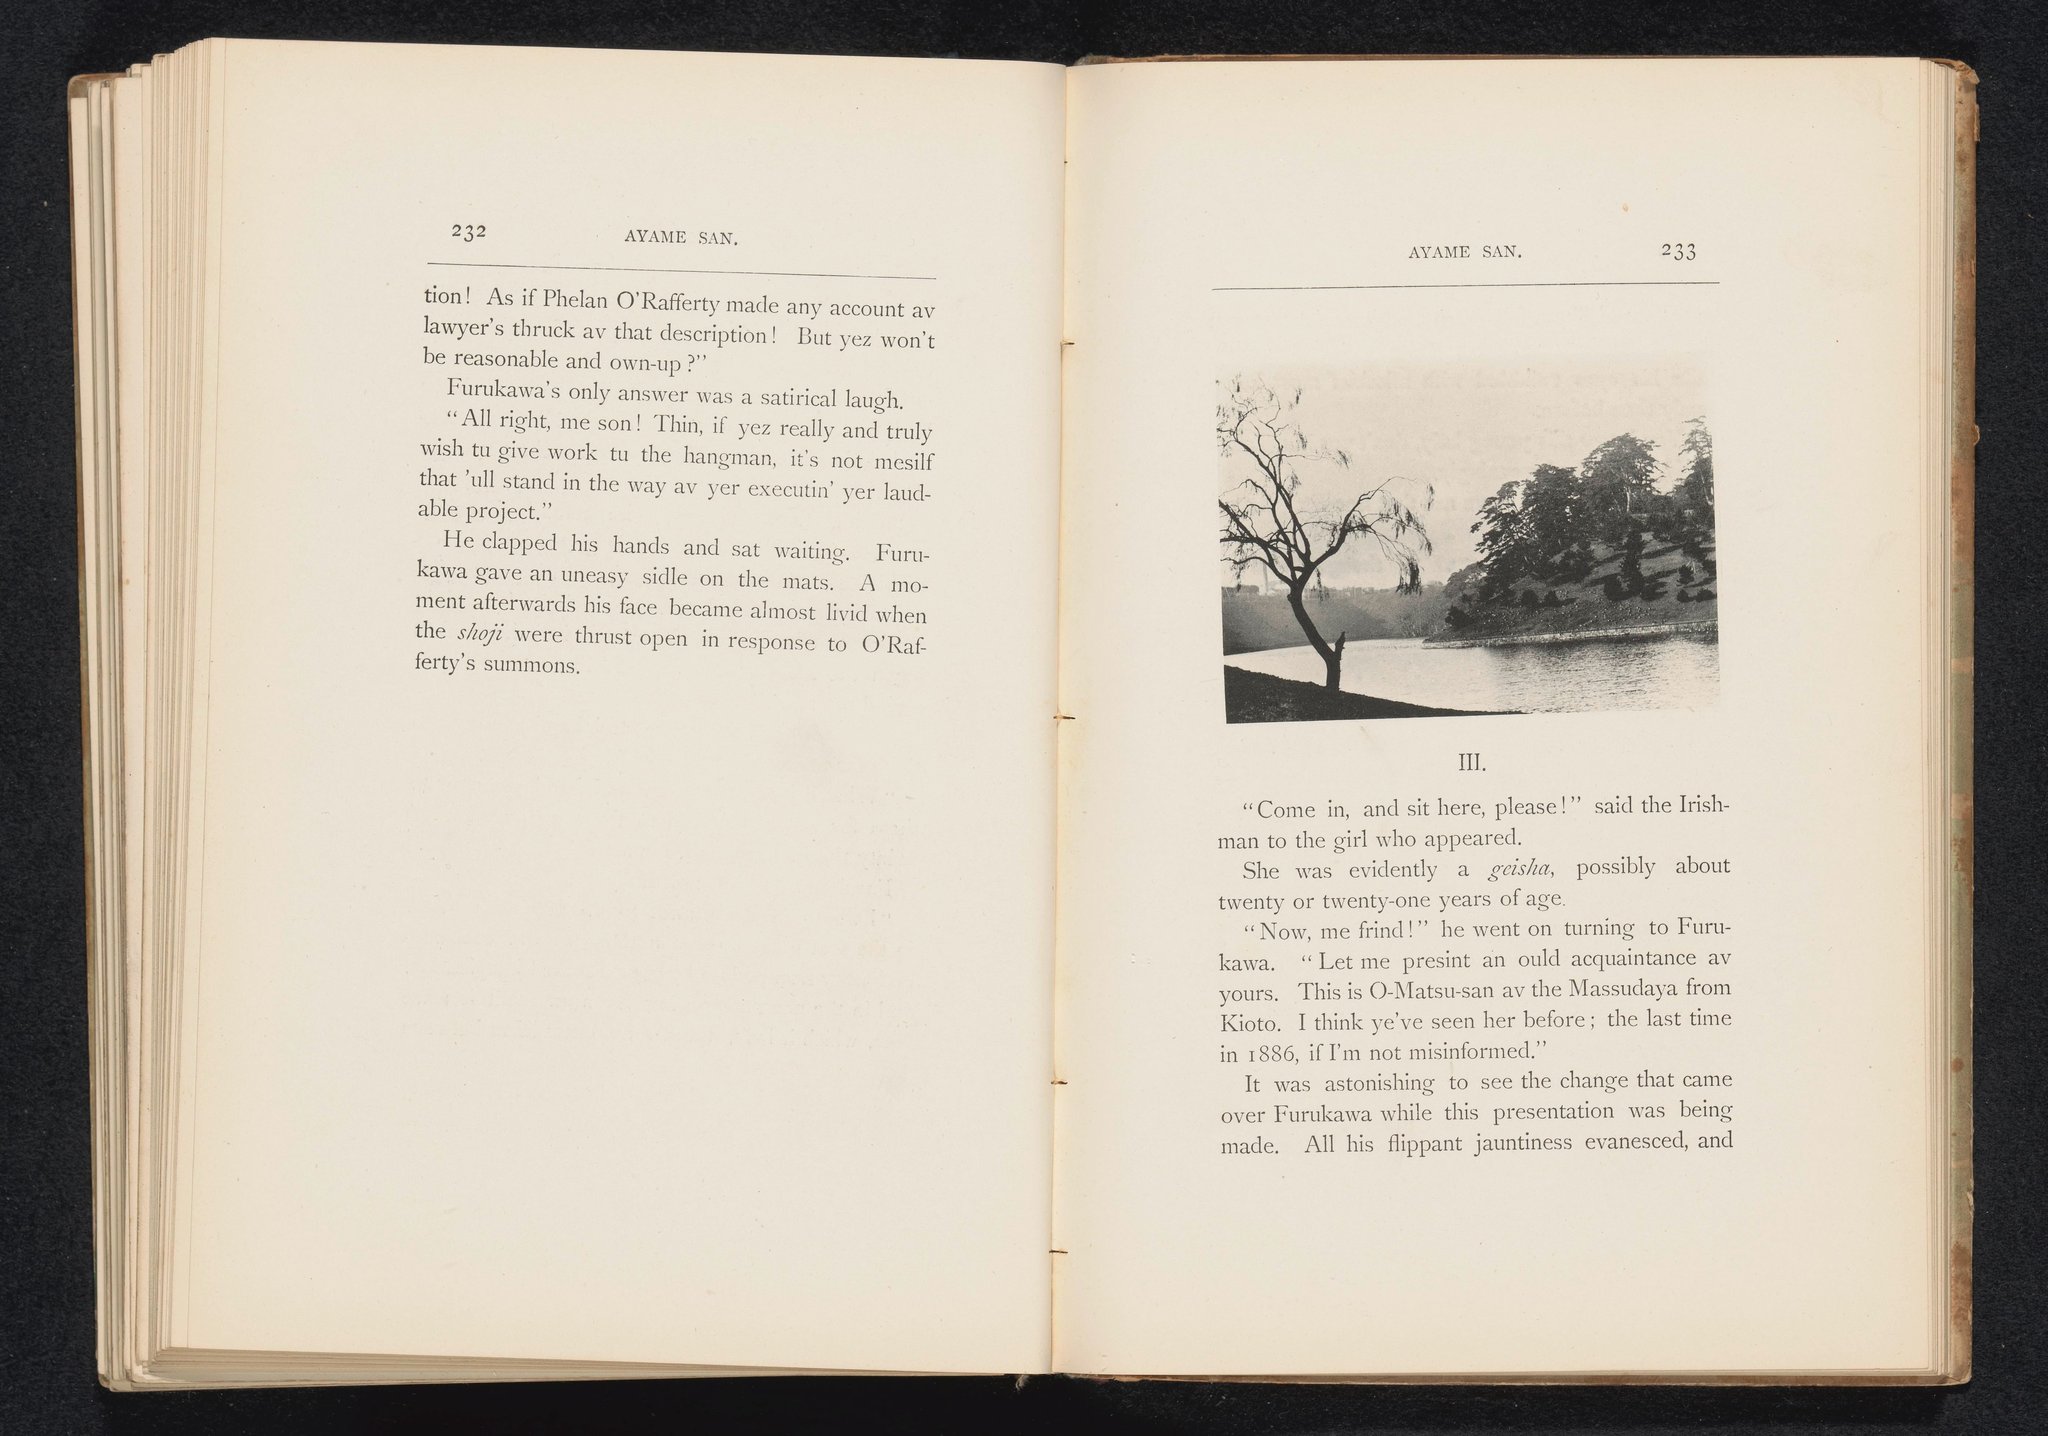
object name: photomechanical print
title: Gezicht op een rivier te Japan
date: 1882-1892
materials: paper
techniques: photograph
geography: japan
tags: river